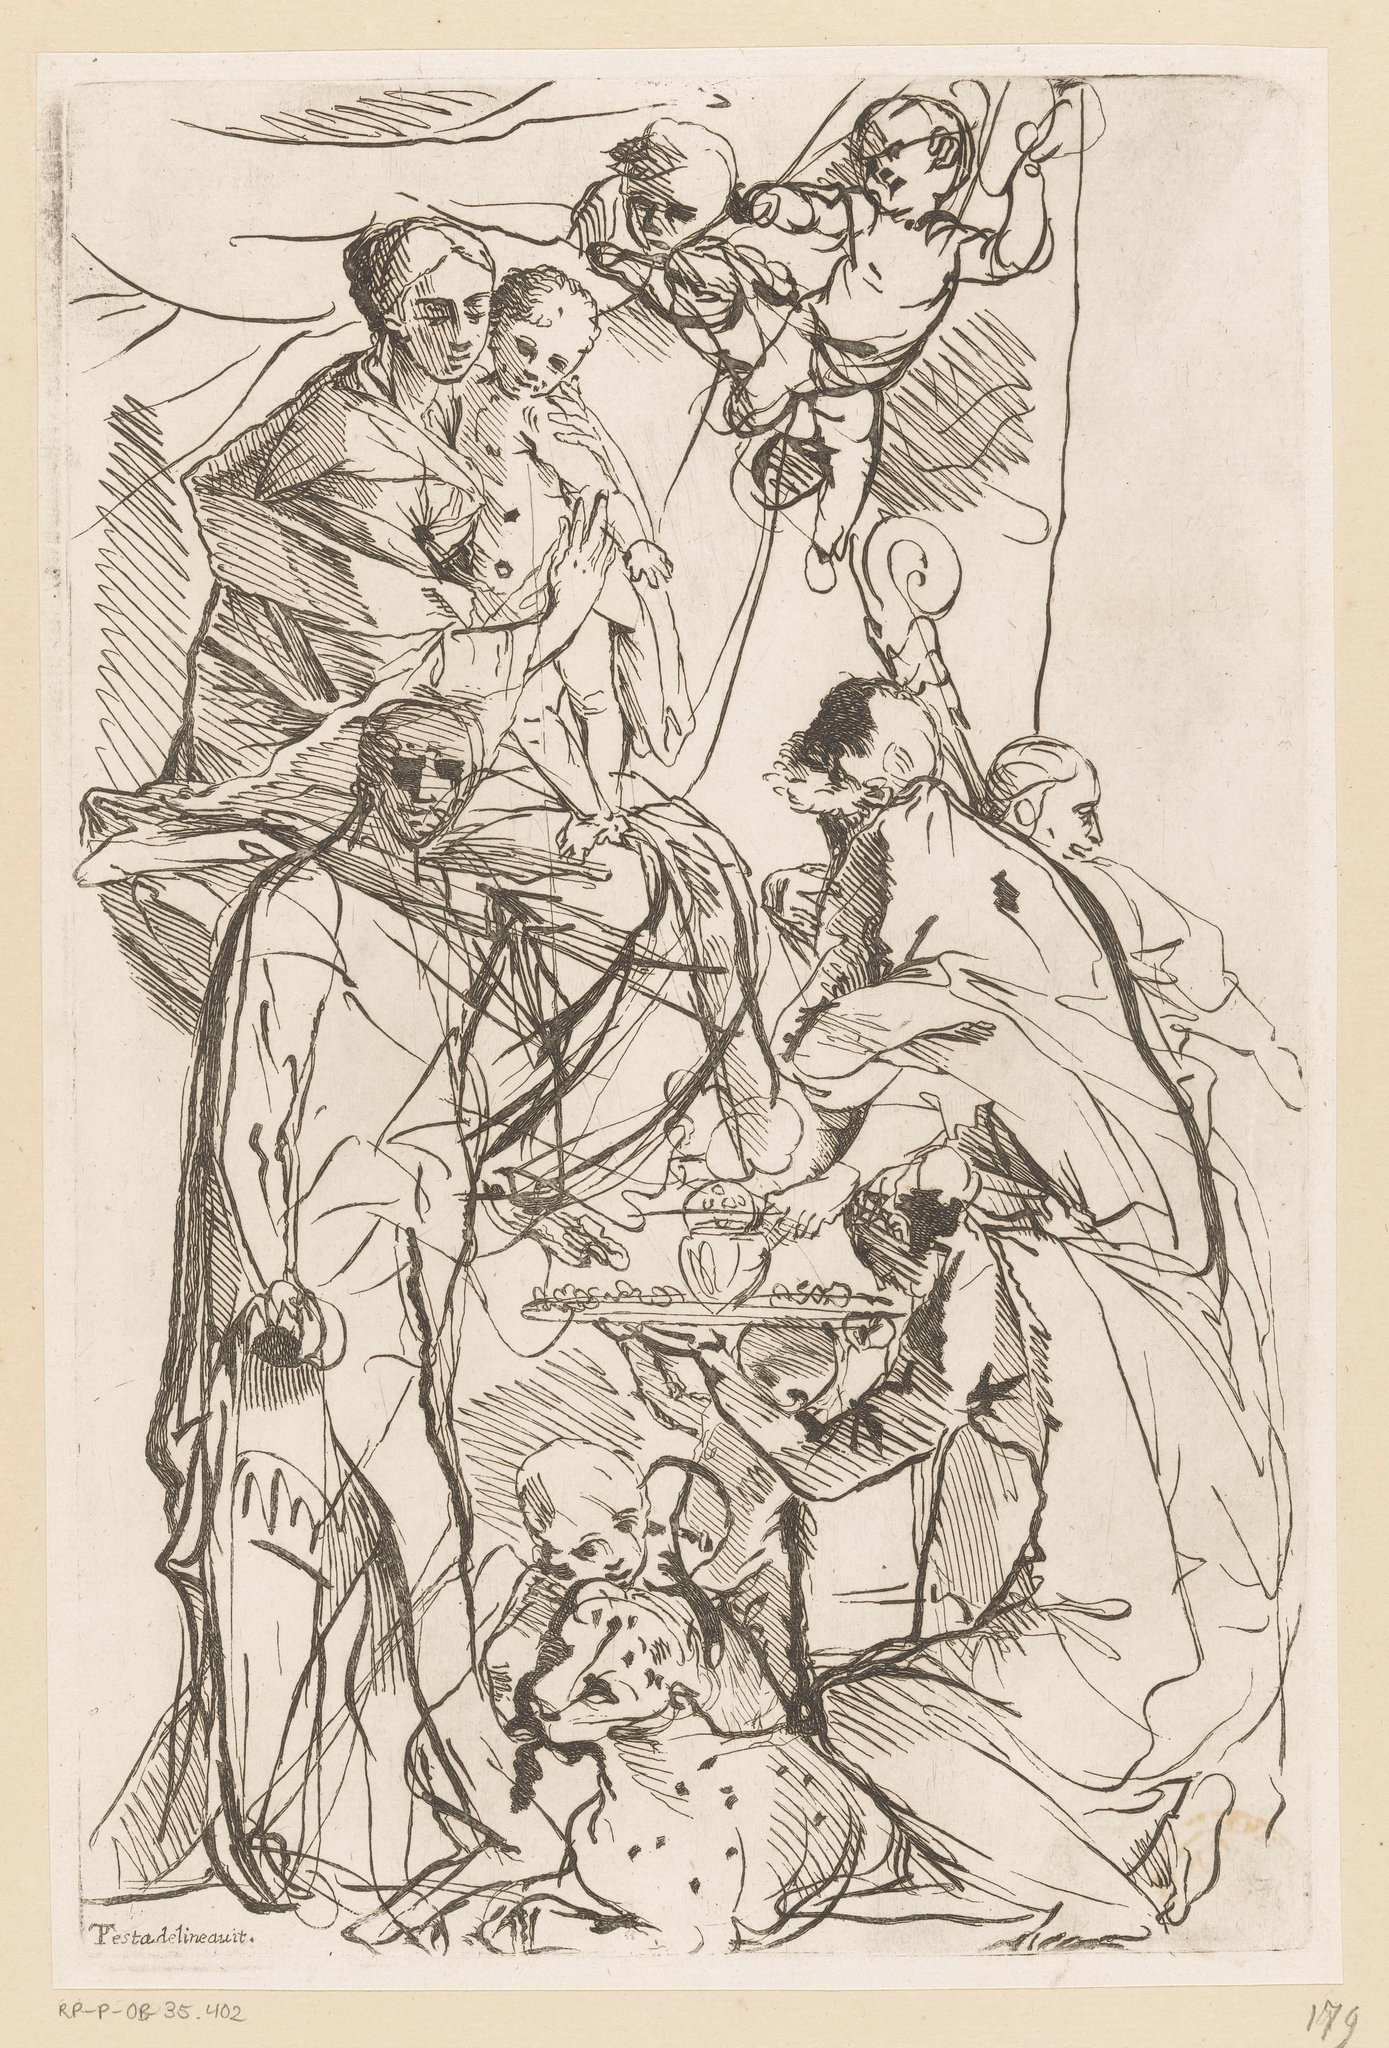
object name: print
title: Aanbidding van Maria met Christuskind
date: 1650-1750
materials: paper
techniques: etching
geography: italy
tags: madonna accompanied by saint(s)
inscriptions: collector's mark: Lugt 240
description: Linksboven zit Maria met het Christuskind op schoot op een verhoging voor een draperie. Voor haar staan verschillende figuren (heiligen?), ligt een panter en zitten putti.